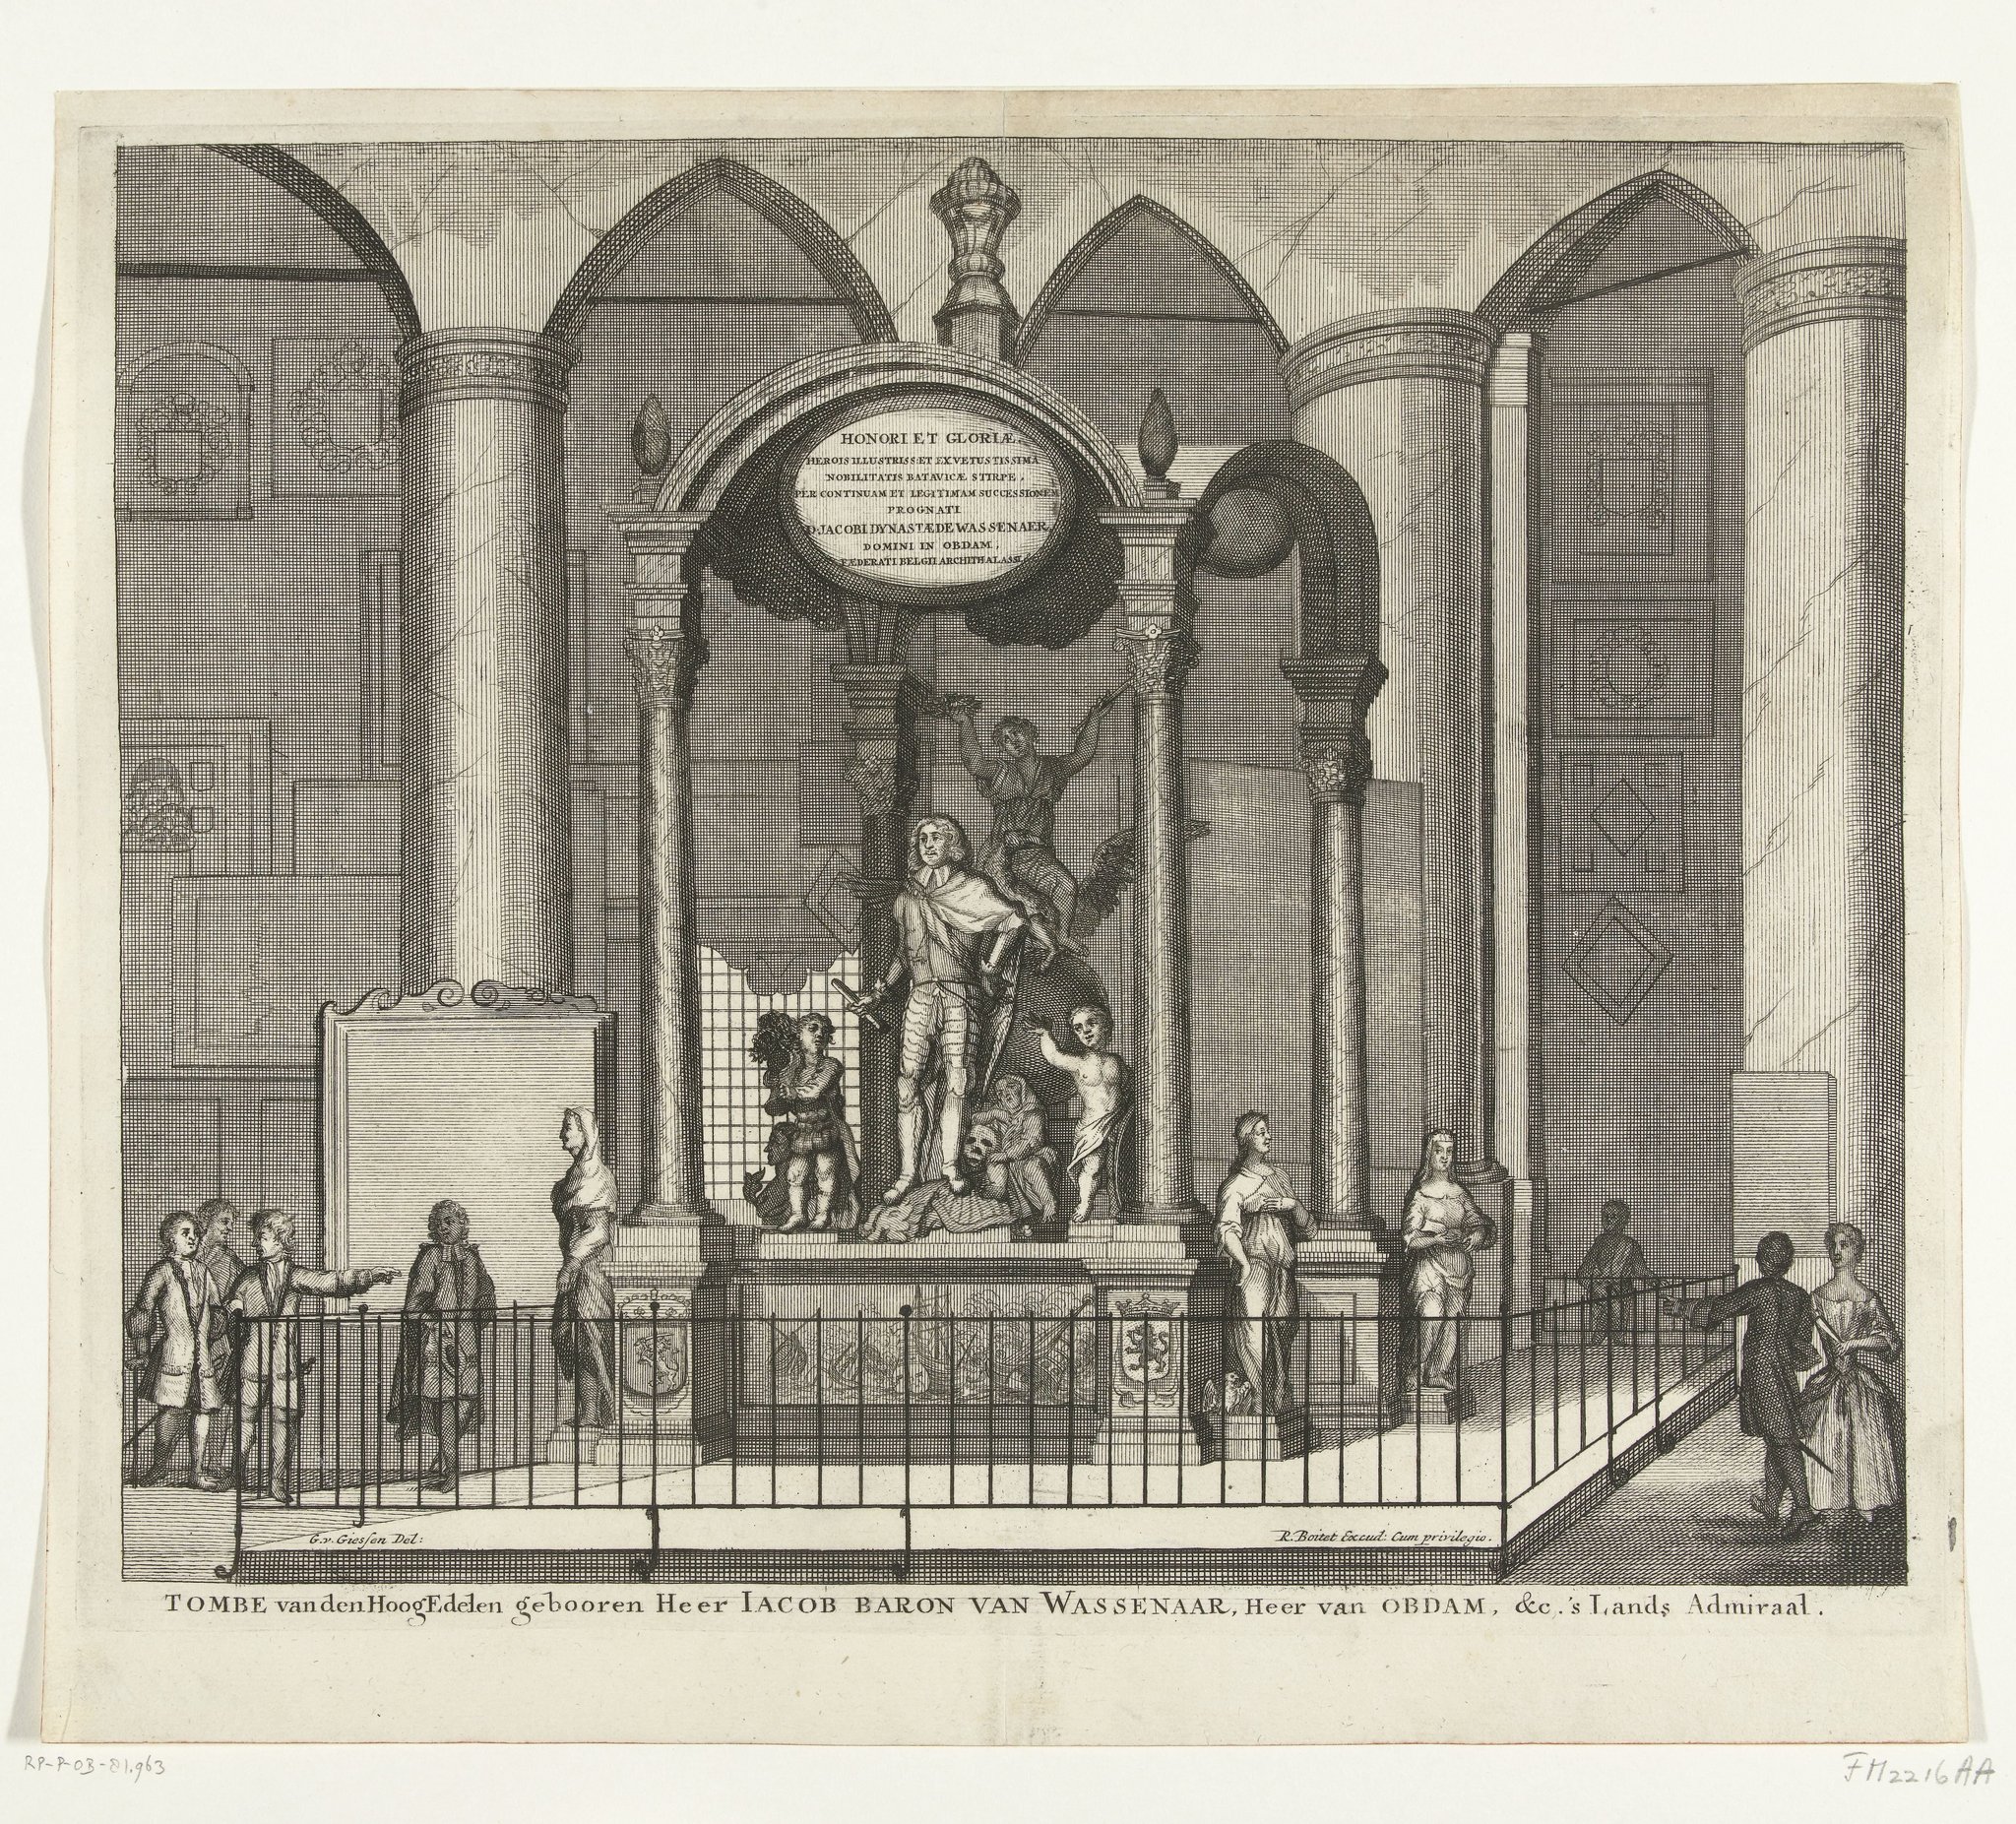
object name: historical object representation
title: Tombe van den Hoog Edelen gebooren Heer Jacob Baron van wassenaar, Heer van Obdam, &c. 's Lands Admiraal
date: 1730-1736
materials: paper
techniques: etching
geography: northern netherlands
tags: jacob baron van wassenaer heer van obdam, grave-building, monumental tomb, battle of lowestoft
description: Praalgraf voor admiraal Jacob baron van Wassenaer van Obdam in de Grote of Sint-Jacobskerk te Den Haag. De admiraal kwam om het leven bij de ontploffing van zijn vlaggenschip de Eendracht tijdens de slag bij Lowestoft op 13 juni 1665.